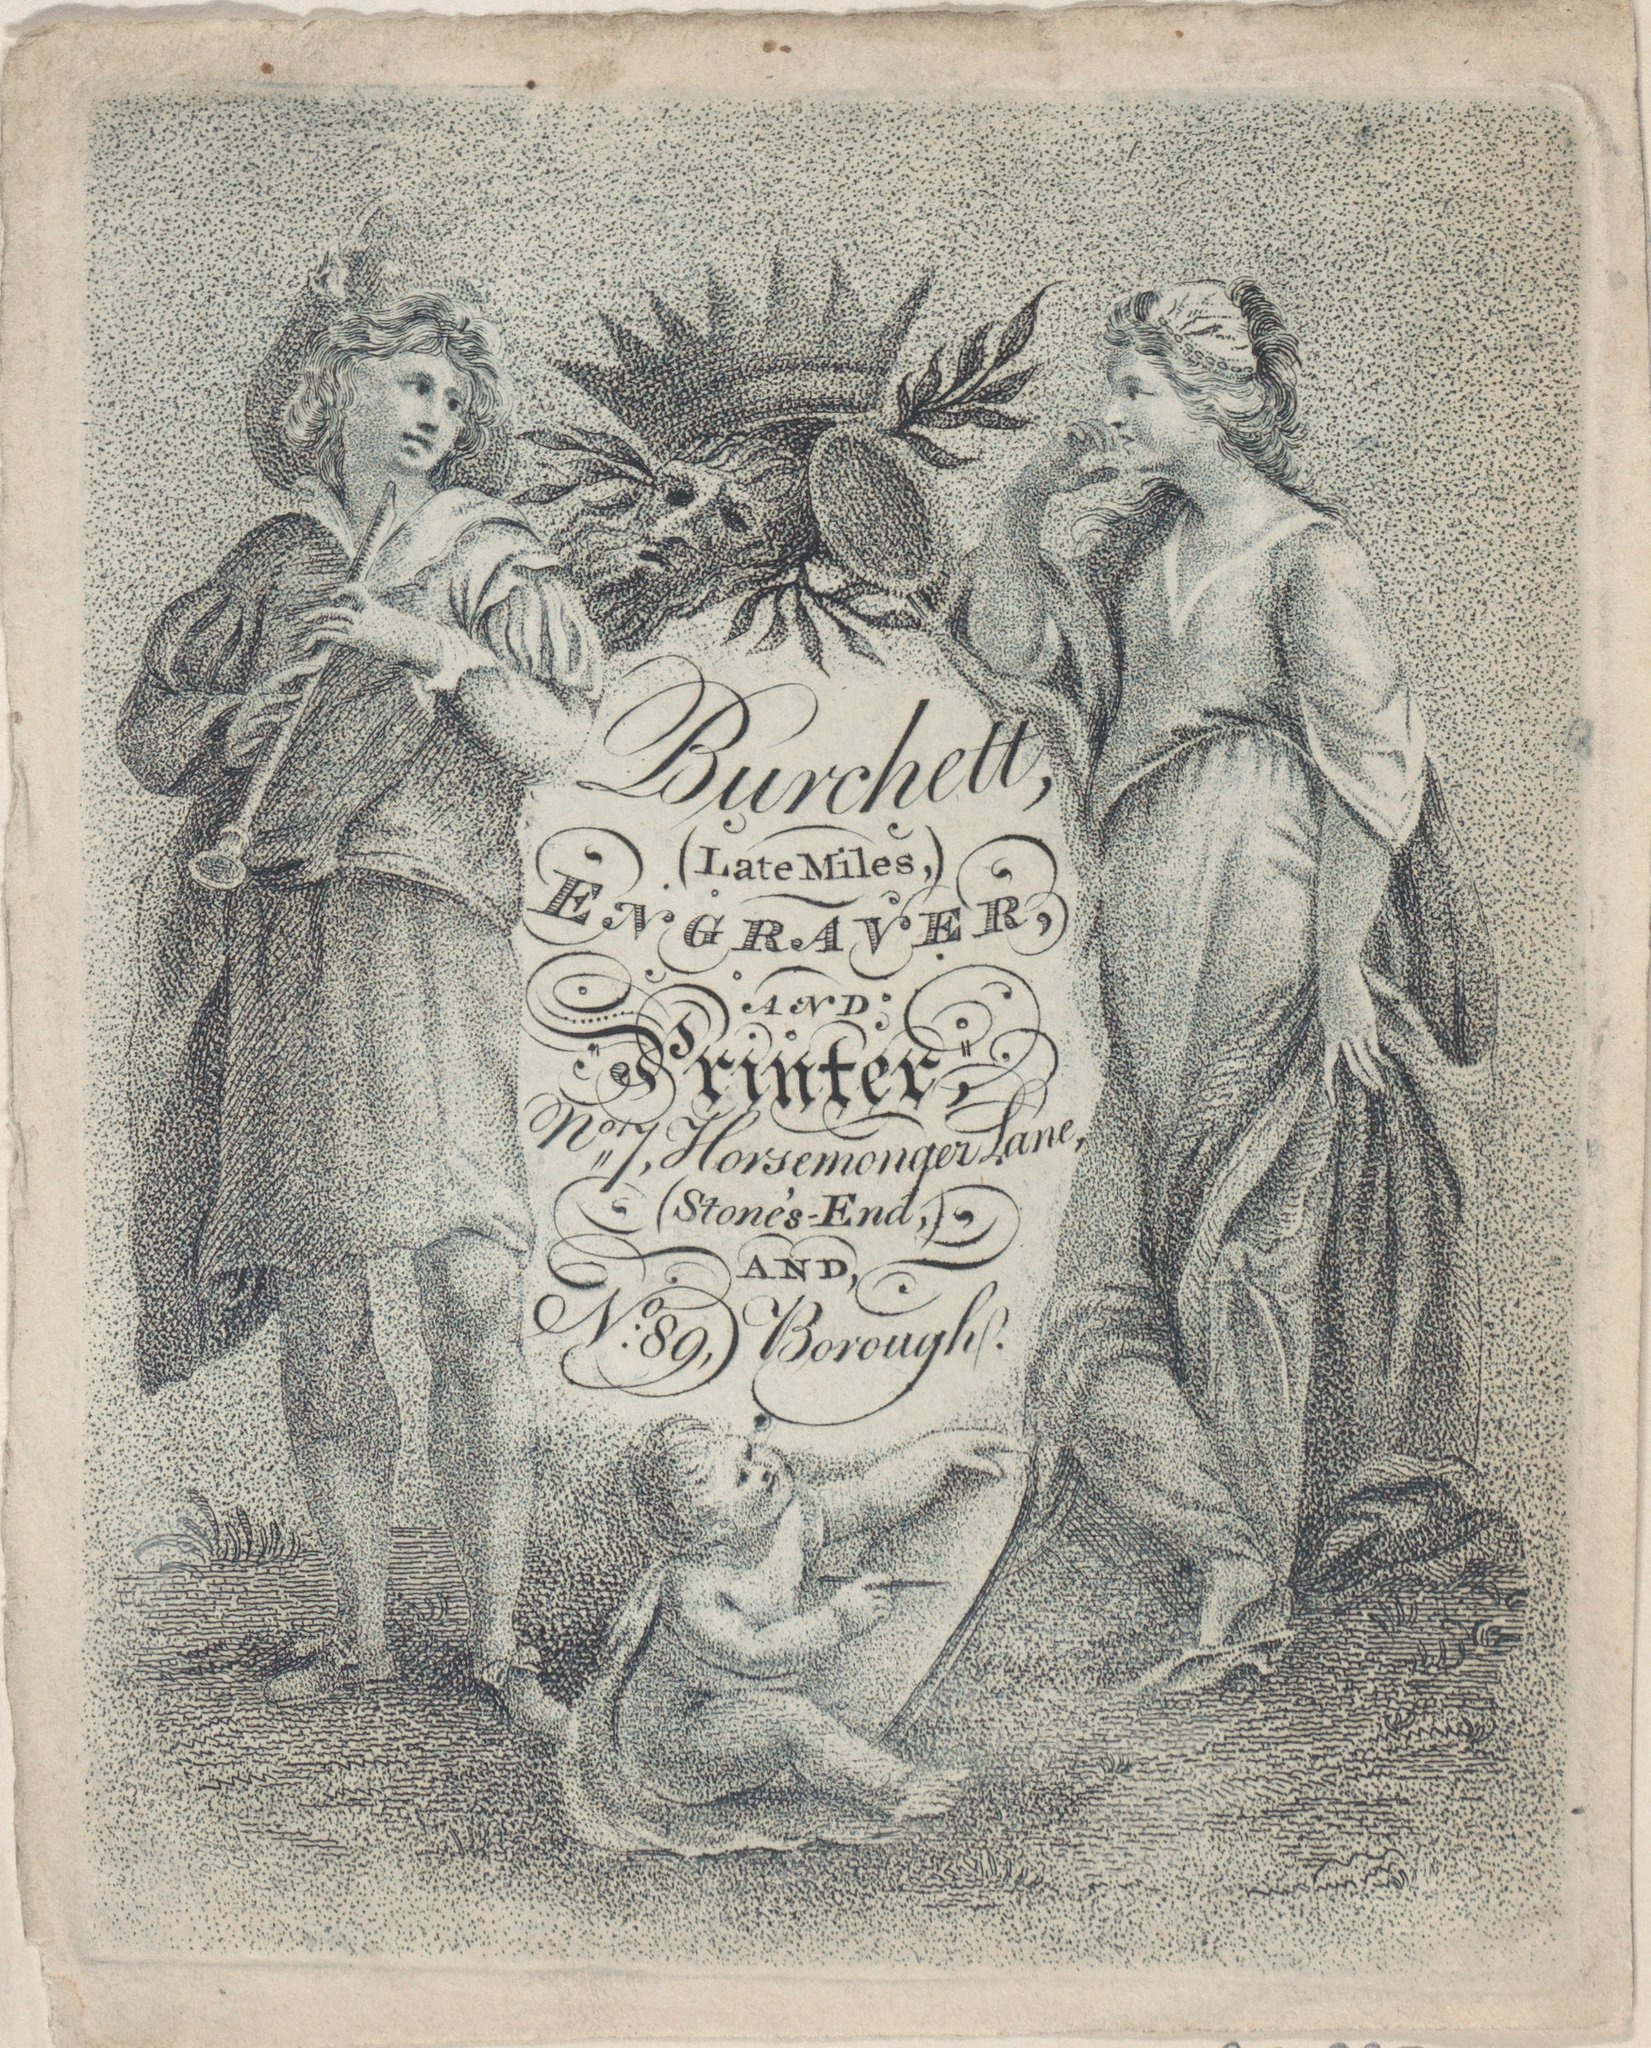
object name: print, trade card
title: Trade Card for Burchett, Engraver and Printer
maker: anonymous, british, 19th century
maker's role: artist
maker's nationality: british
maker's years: 1800-1900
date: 1701-1800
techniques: engraving